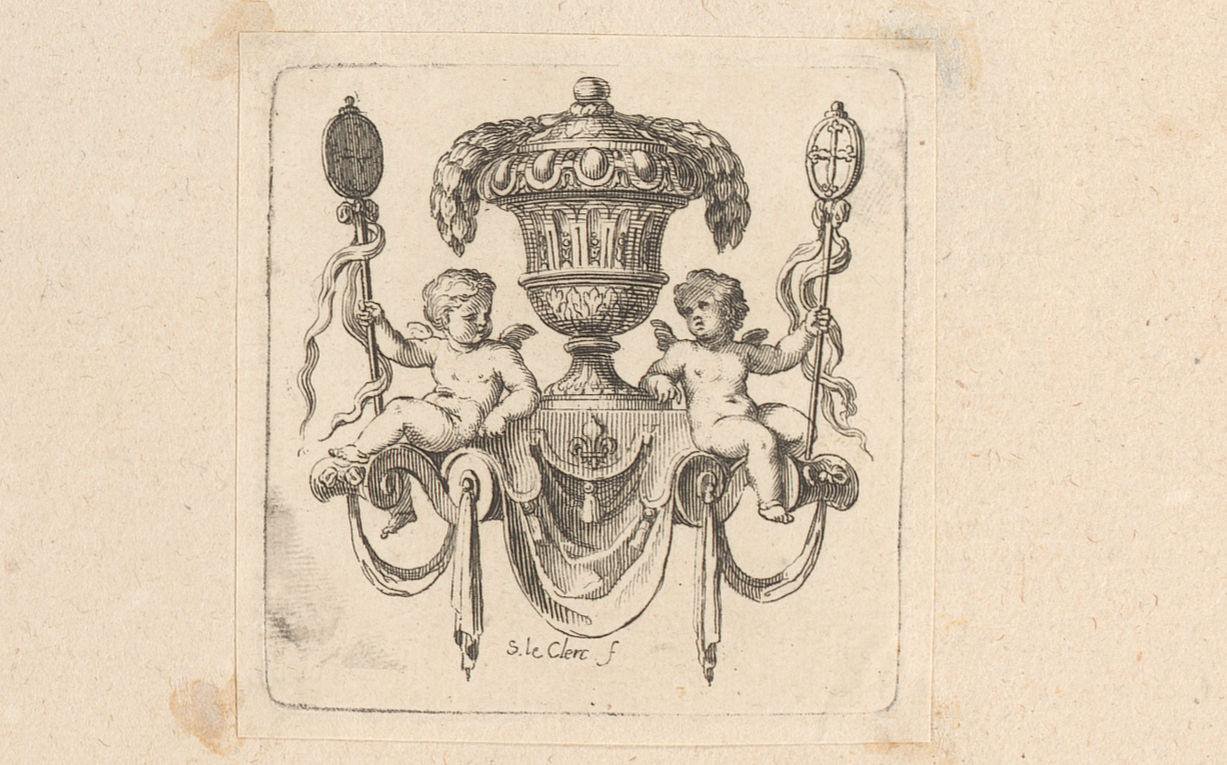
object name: book illustration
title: Cul-de-lampe met twee cherubijnen naast een vaas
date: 1687-1701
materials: paper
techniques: etching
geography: toulouse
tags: cherubs, i.e. children's heads with wings, vase ~ ornament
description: Prent waarschijnlijk gebruikt voor: La Faille, Germain de. Annales de la ville de Toulouse depuis la réunion de la Comté de Toulouse à la couronne (...). Toulouse: Guillaume-Louis Colomyez en Jérôme Posuel, 1687-1701.